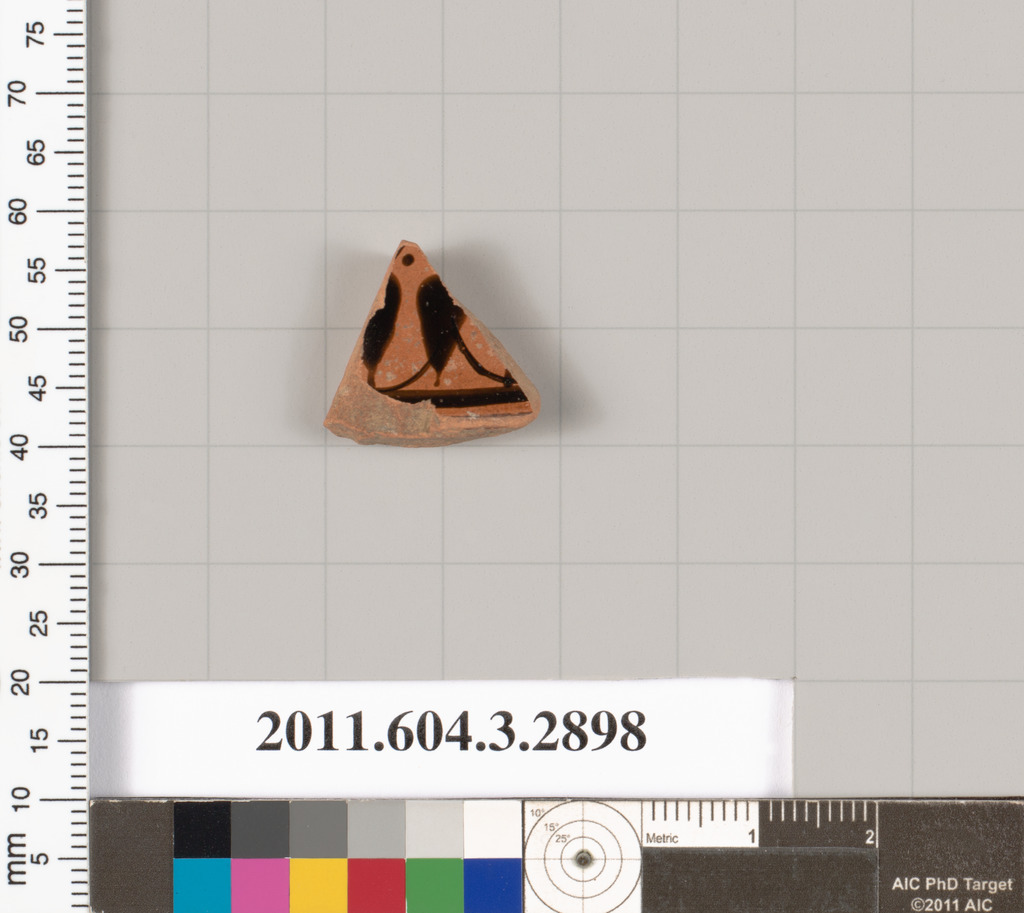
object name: undetermined closed shape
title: Terracotta fragment of a closed shape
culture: greek, attic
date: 525-501 BCE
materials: terracotta